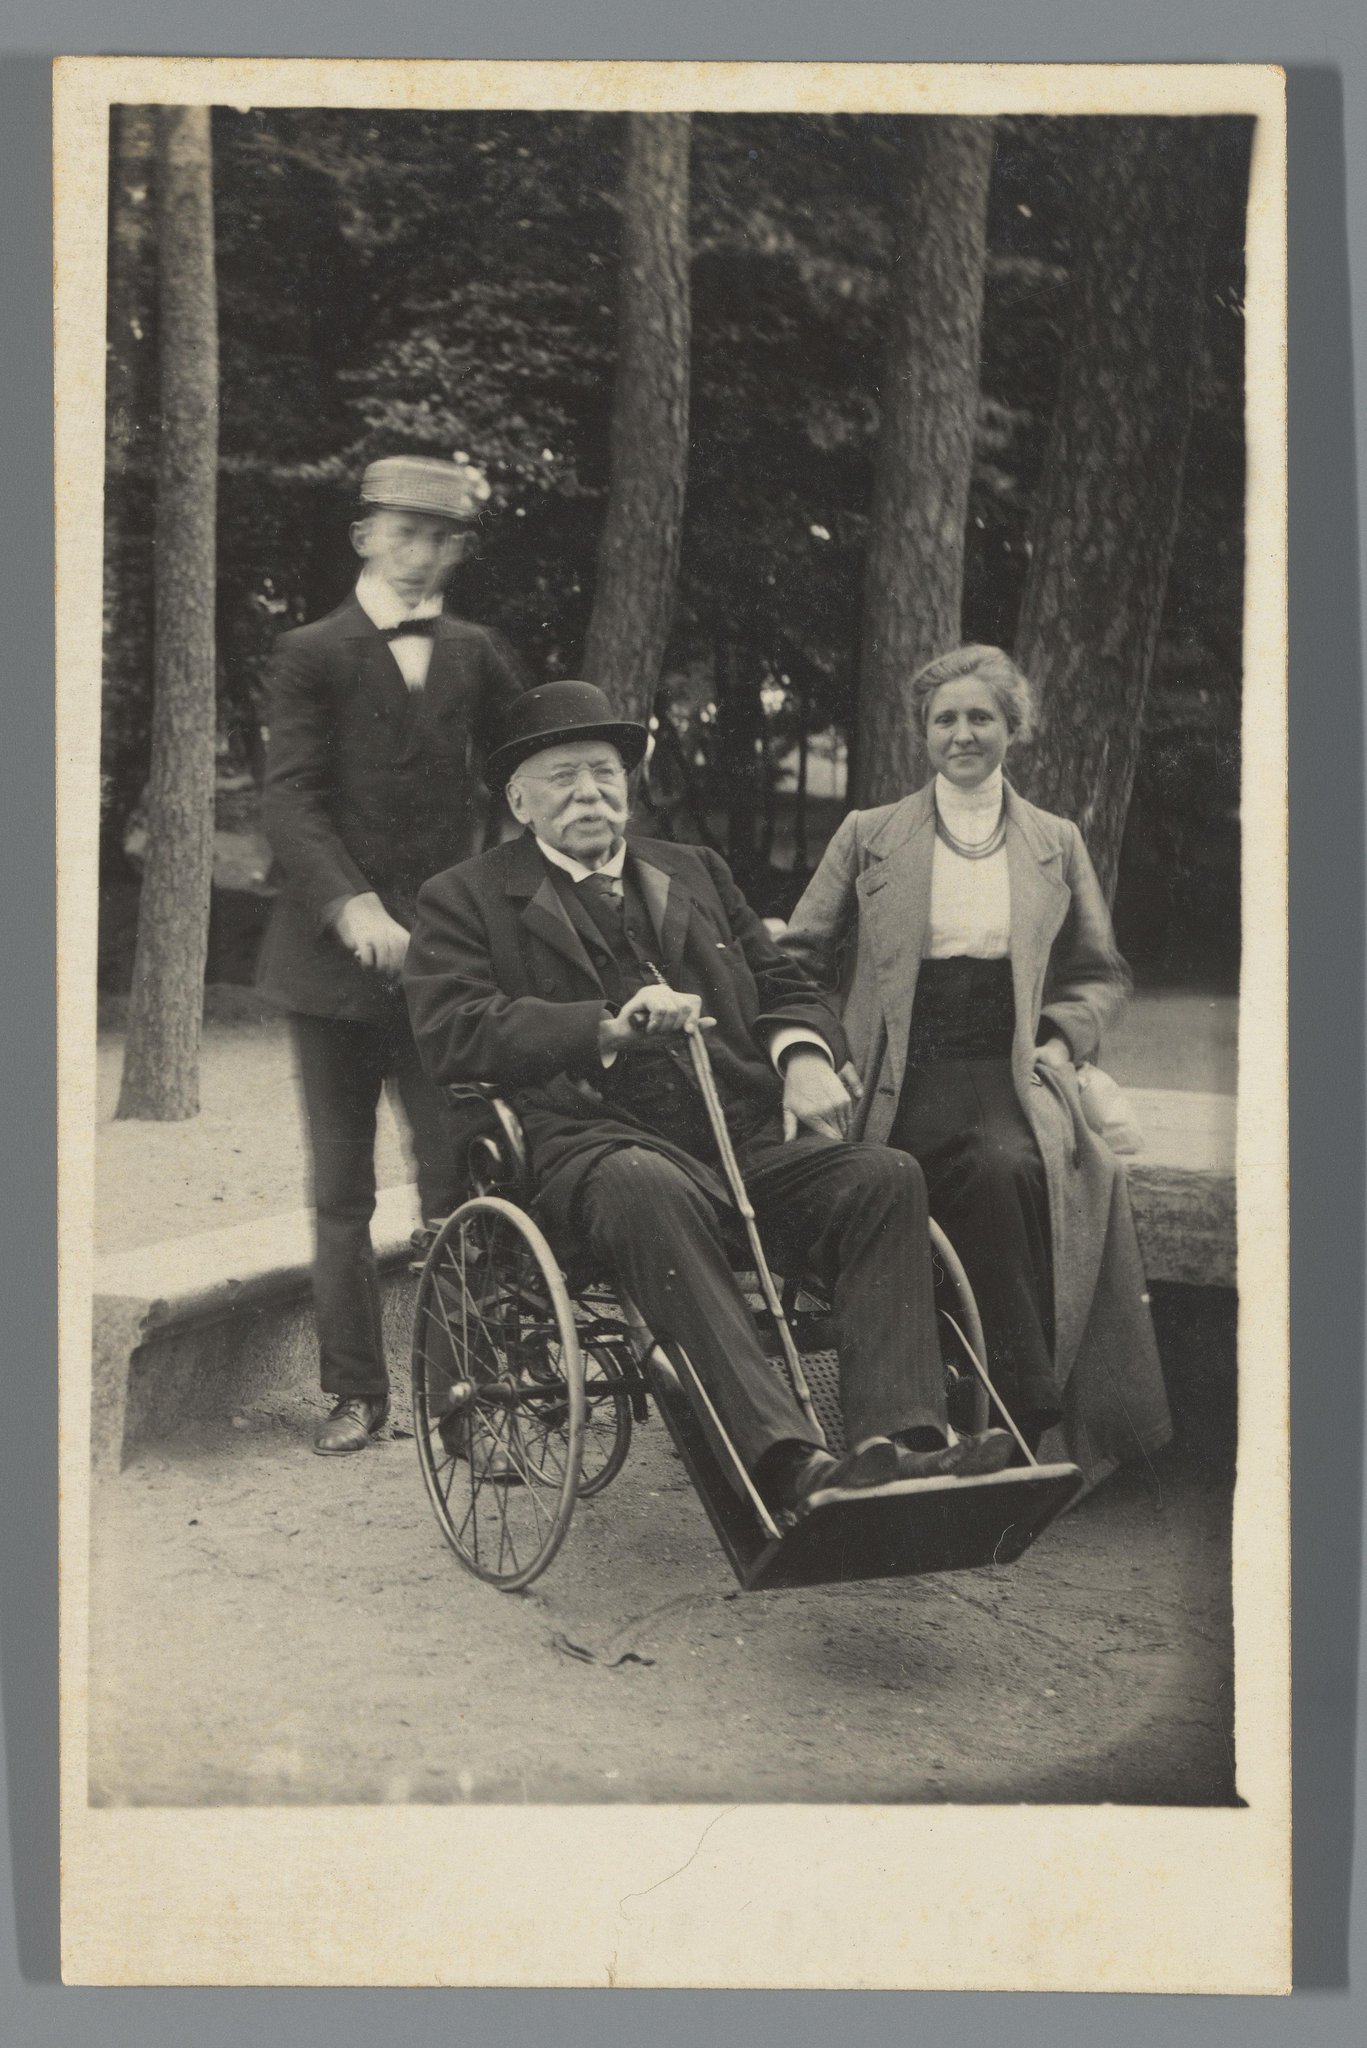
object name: ansichtkaart, prentbriefkaart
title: Norbert van den Berg in een rolstoel met een man en vrouw achter en naast hem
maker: Anonymous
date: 1912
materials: photographic support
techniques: albumen print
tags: rotterdam, amsterdam, norbertus petrus van den berg (1831-1917)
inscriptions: inscription: ‘Klarenbeek 1912’